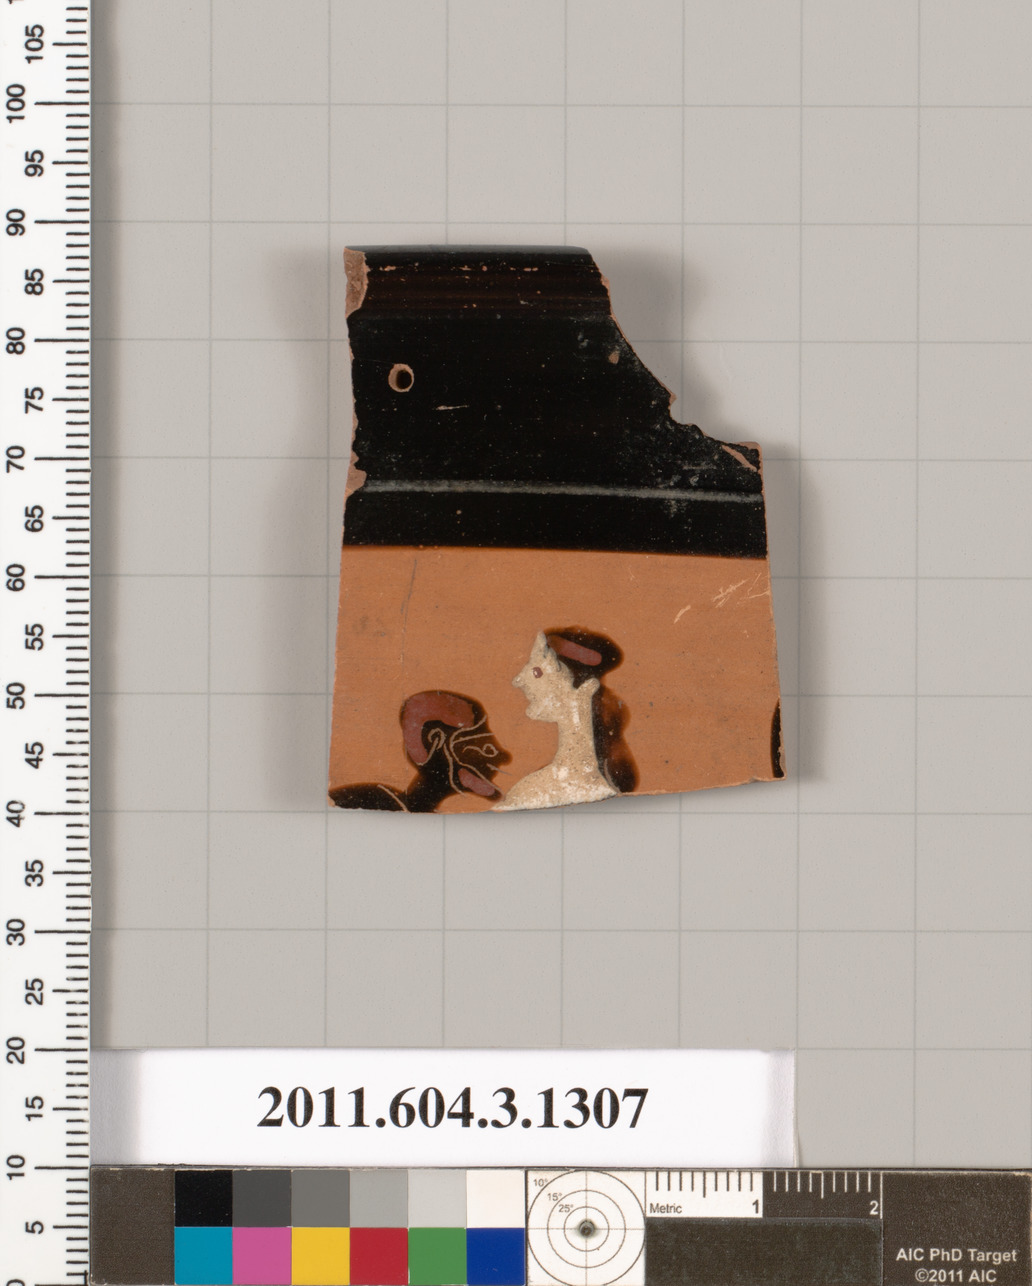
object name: skyphos fragment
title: Terracotta rim fragment of a skyphos (deep drinking cup)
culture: greek, attic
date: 500-468 BCE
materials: terracotta